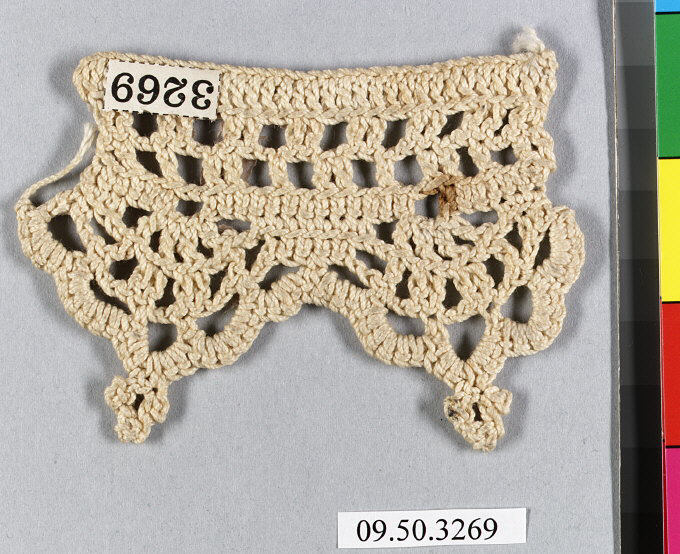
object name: sample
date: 1801-1900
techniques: crochet